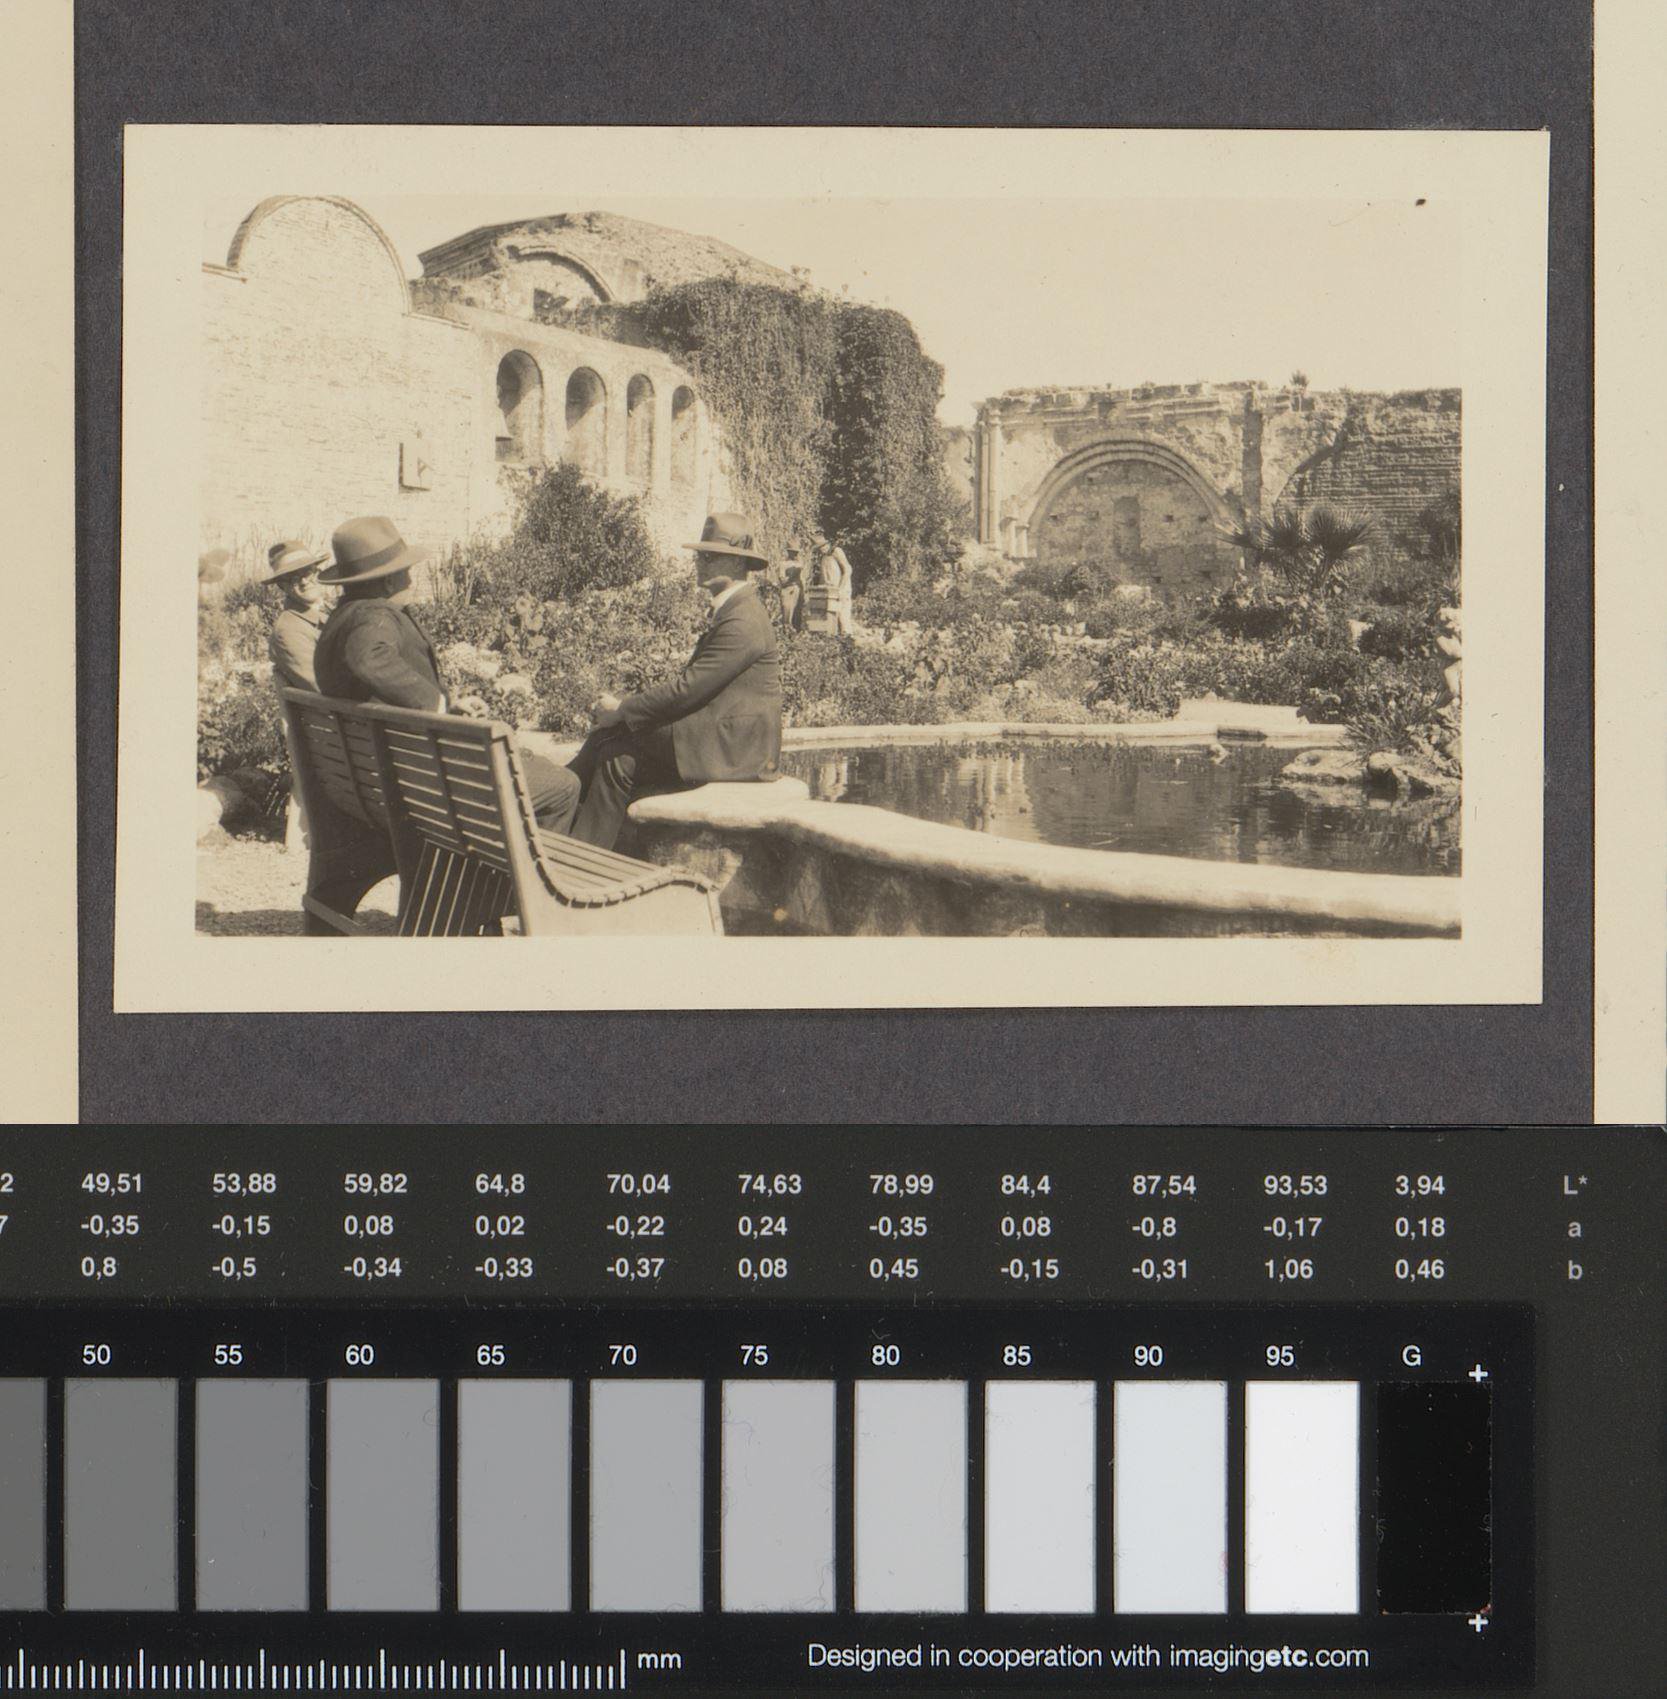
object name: album leaf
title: Vier personen op de binnenplaats van Mission San Juan Capistrano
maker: Anonymous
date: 1928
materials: photographic support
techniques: gelatin silver print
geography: san juan capistrano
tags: historical persons, courtyard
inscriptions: annotation: ‘San Juan Capistrano’